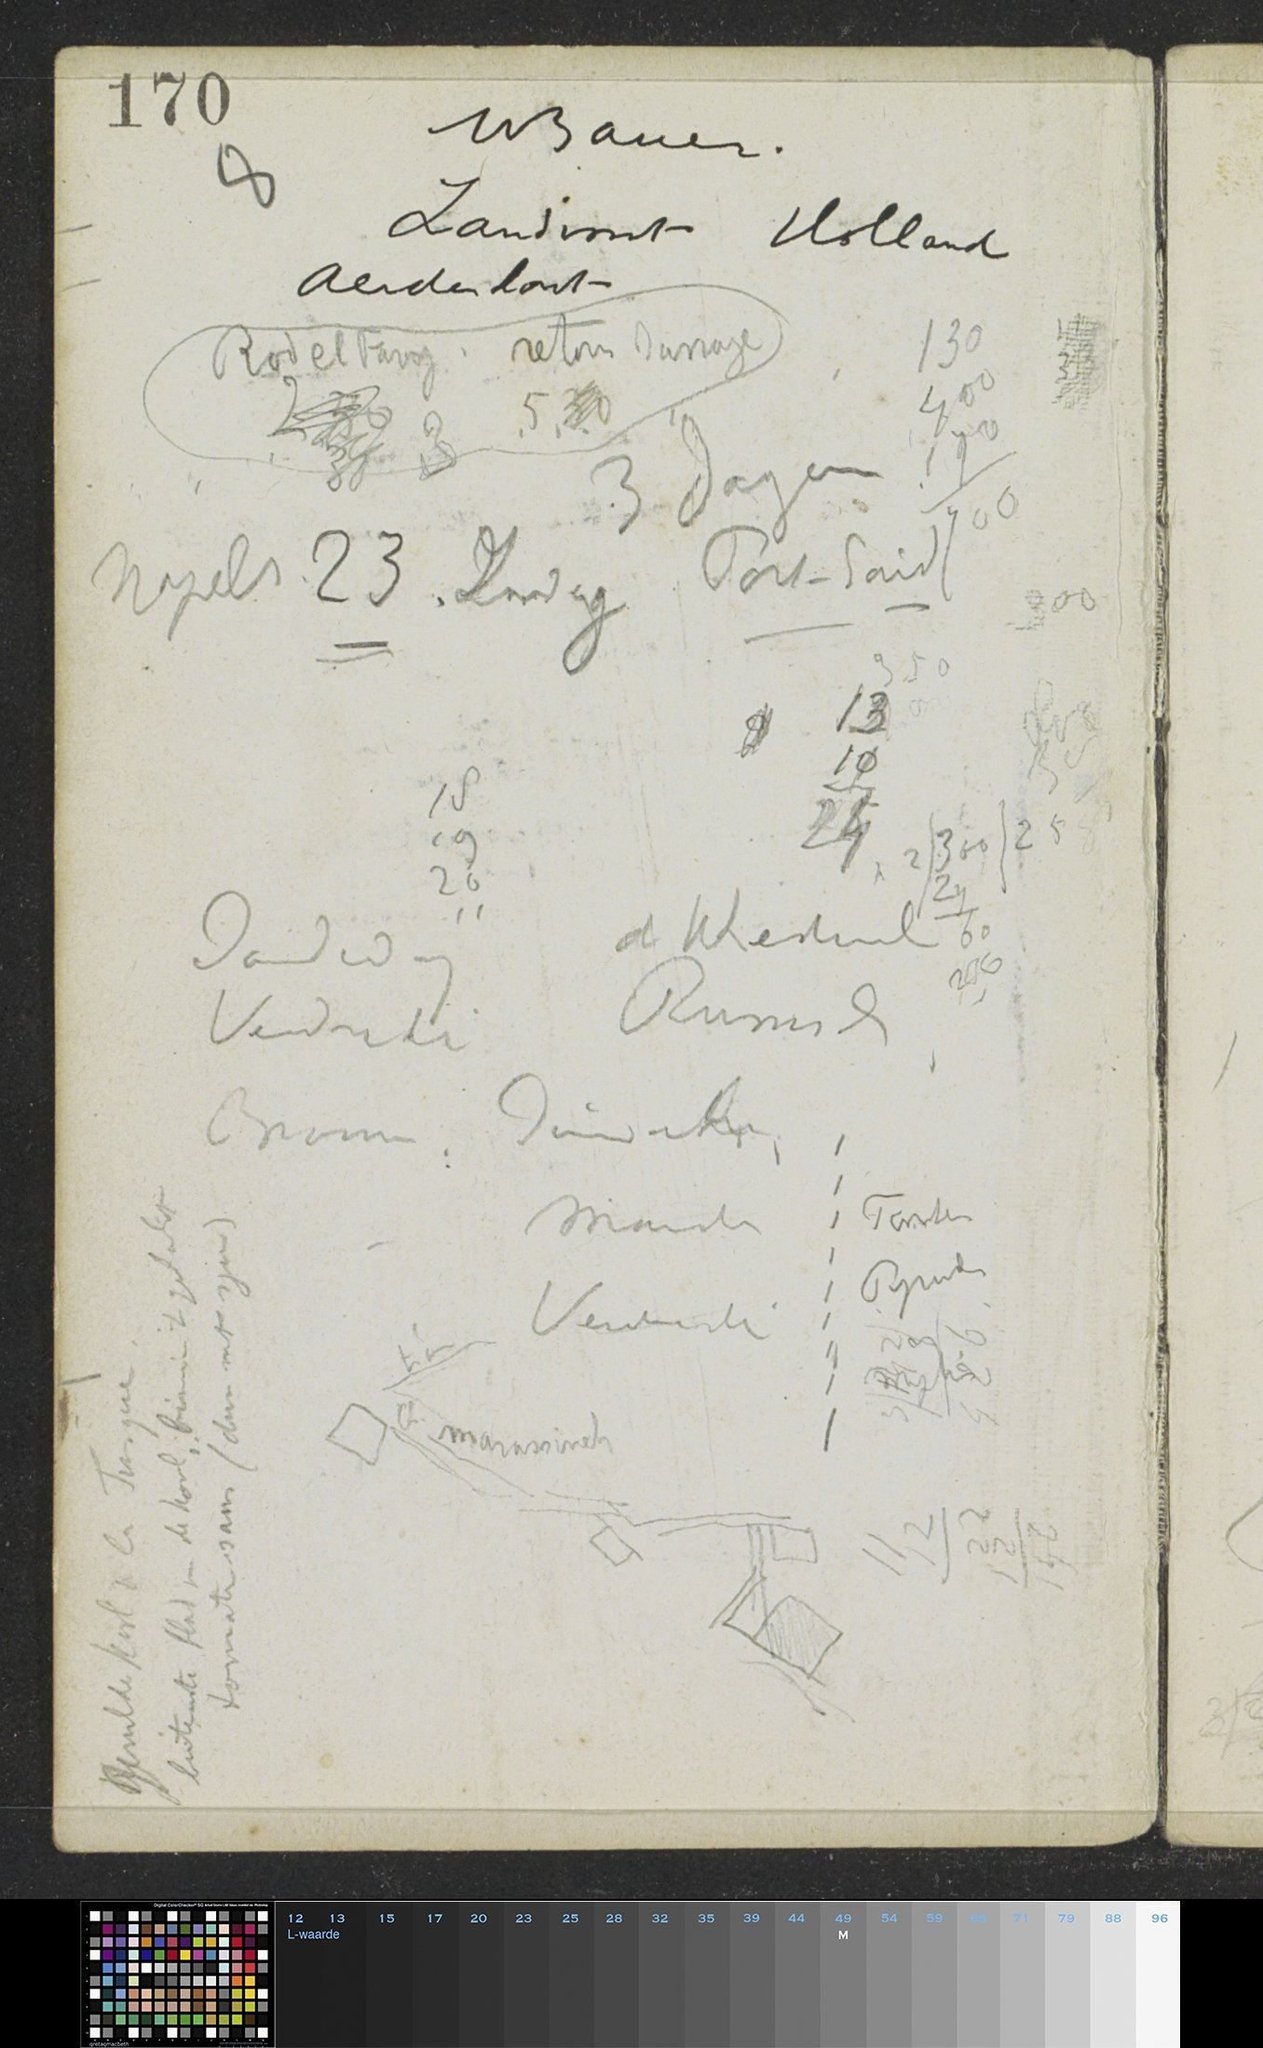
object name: sketchbook leaf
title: Notities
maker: marius bauer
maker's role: draughtsman, print maker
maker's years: 1867-1932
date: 1904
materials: ink, paper, pencil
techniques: pen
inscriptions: annotation: ‘MBauer/ Zandvoort Holland/ Aerdenhout [...] Napels 23 Zondag Port-Said [...]’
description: Voorste schutblad uit een schetsboek met 56 bladen.